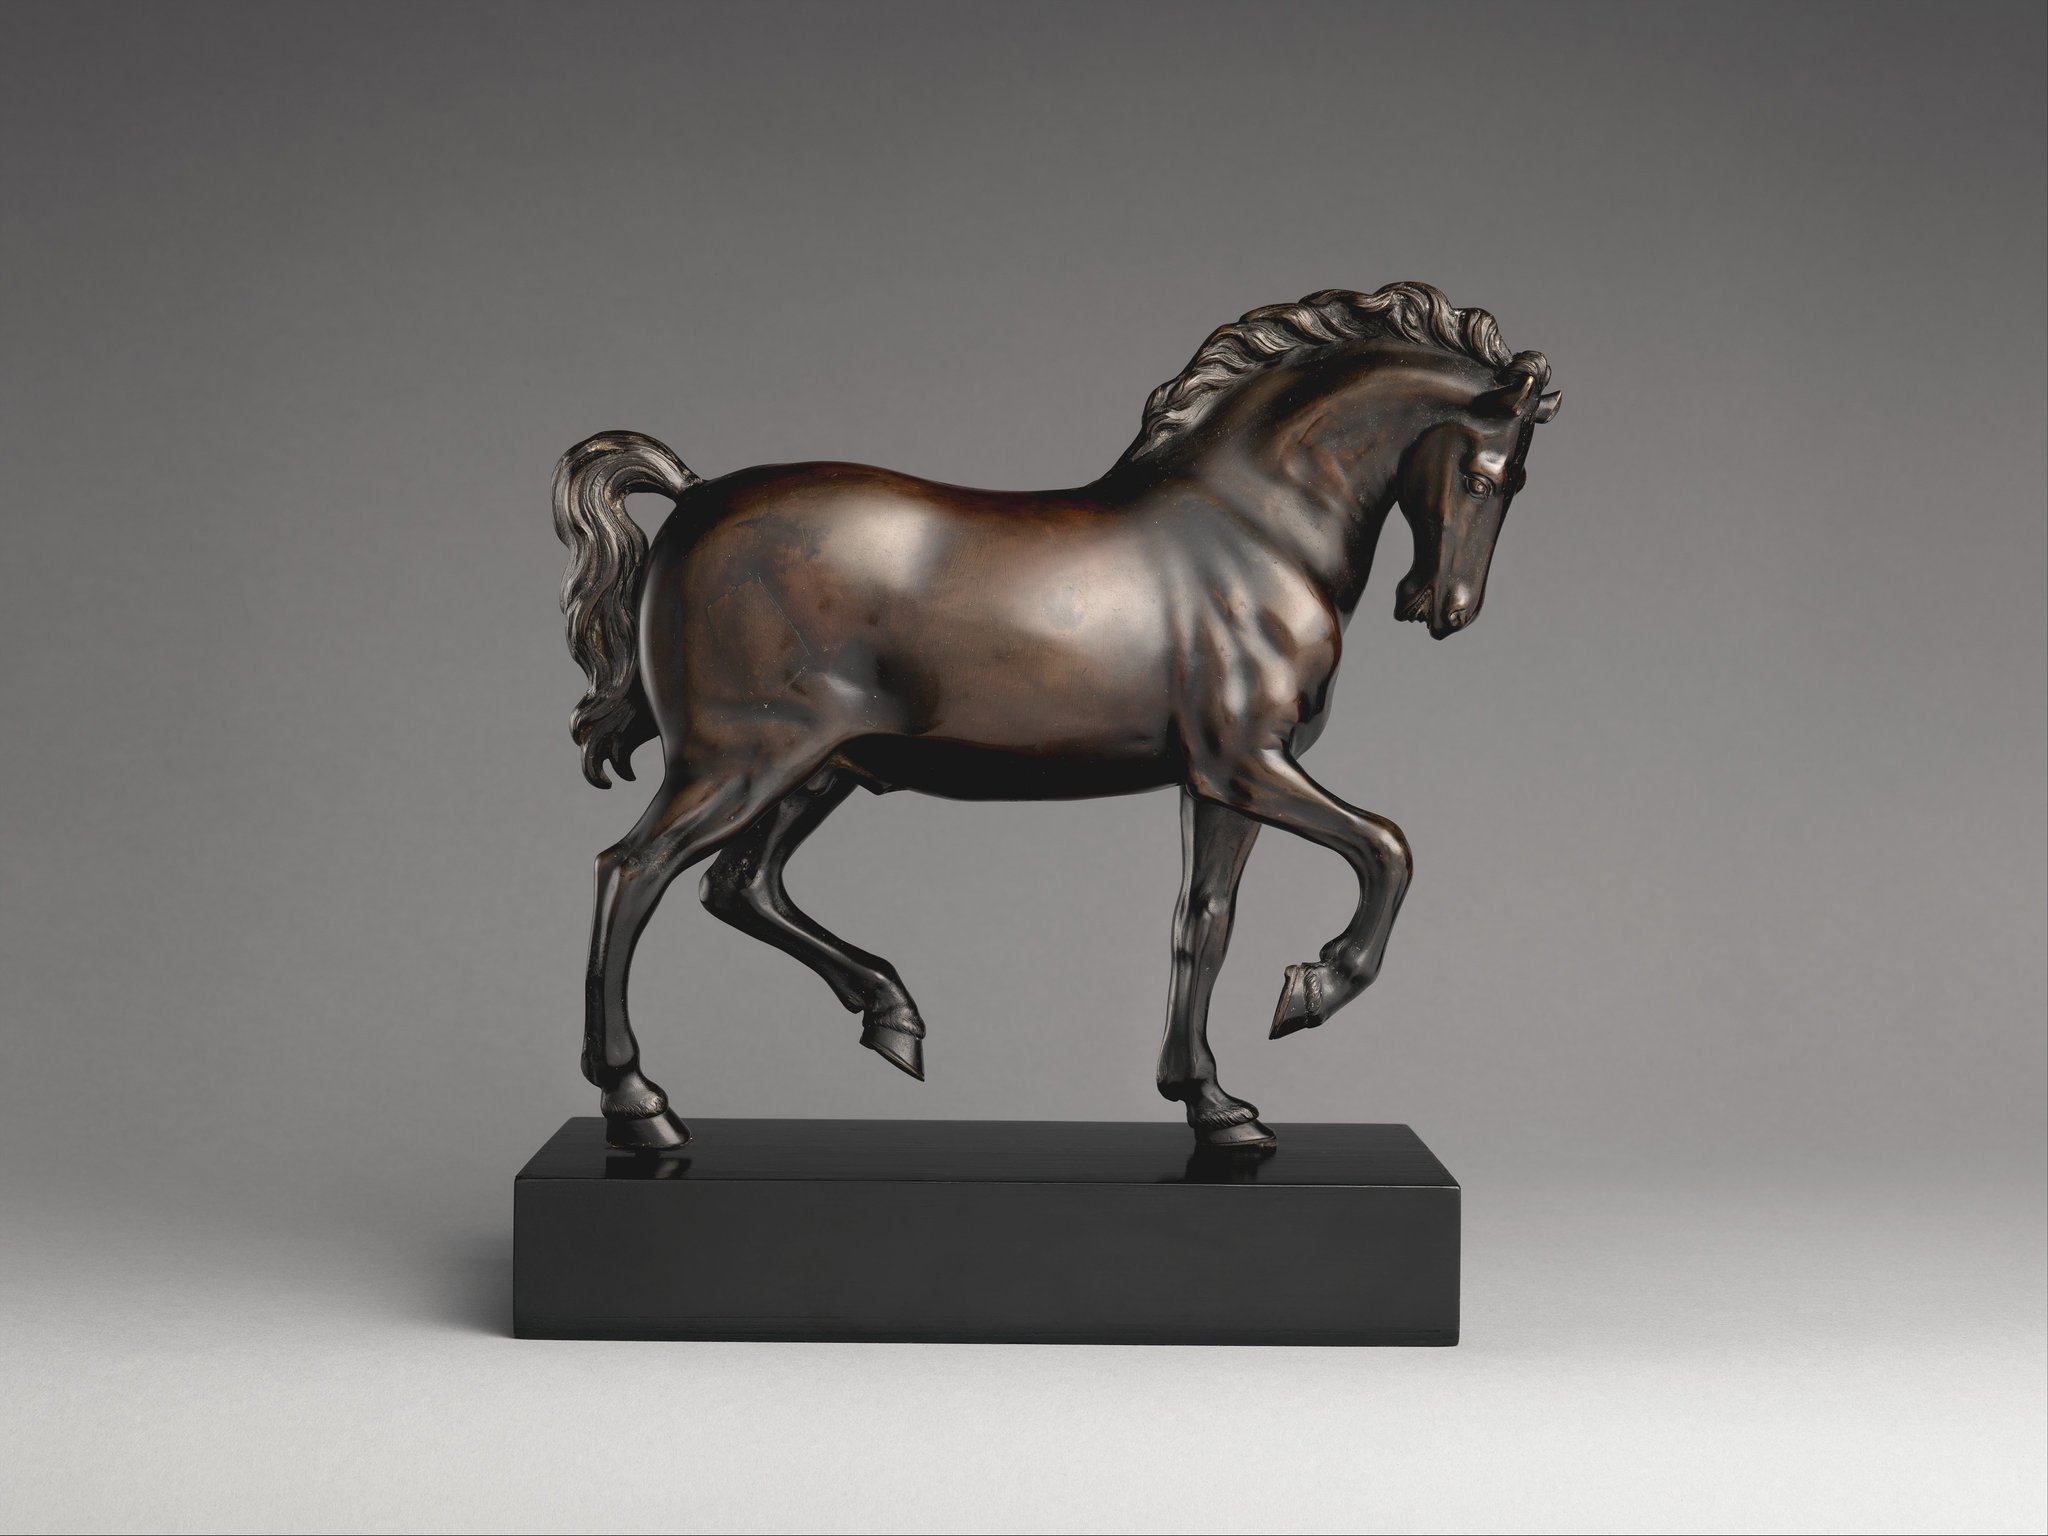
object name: statuette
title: Horse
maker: giambologna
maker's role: artist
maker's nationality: netherlandish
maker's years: 1529-1608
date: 1701-1900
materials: bronze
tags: horses